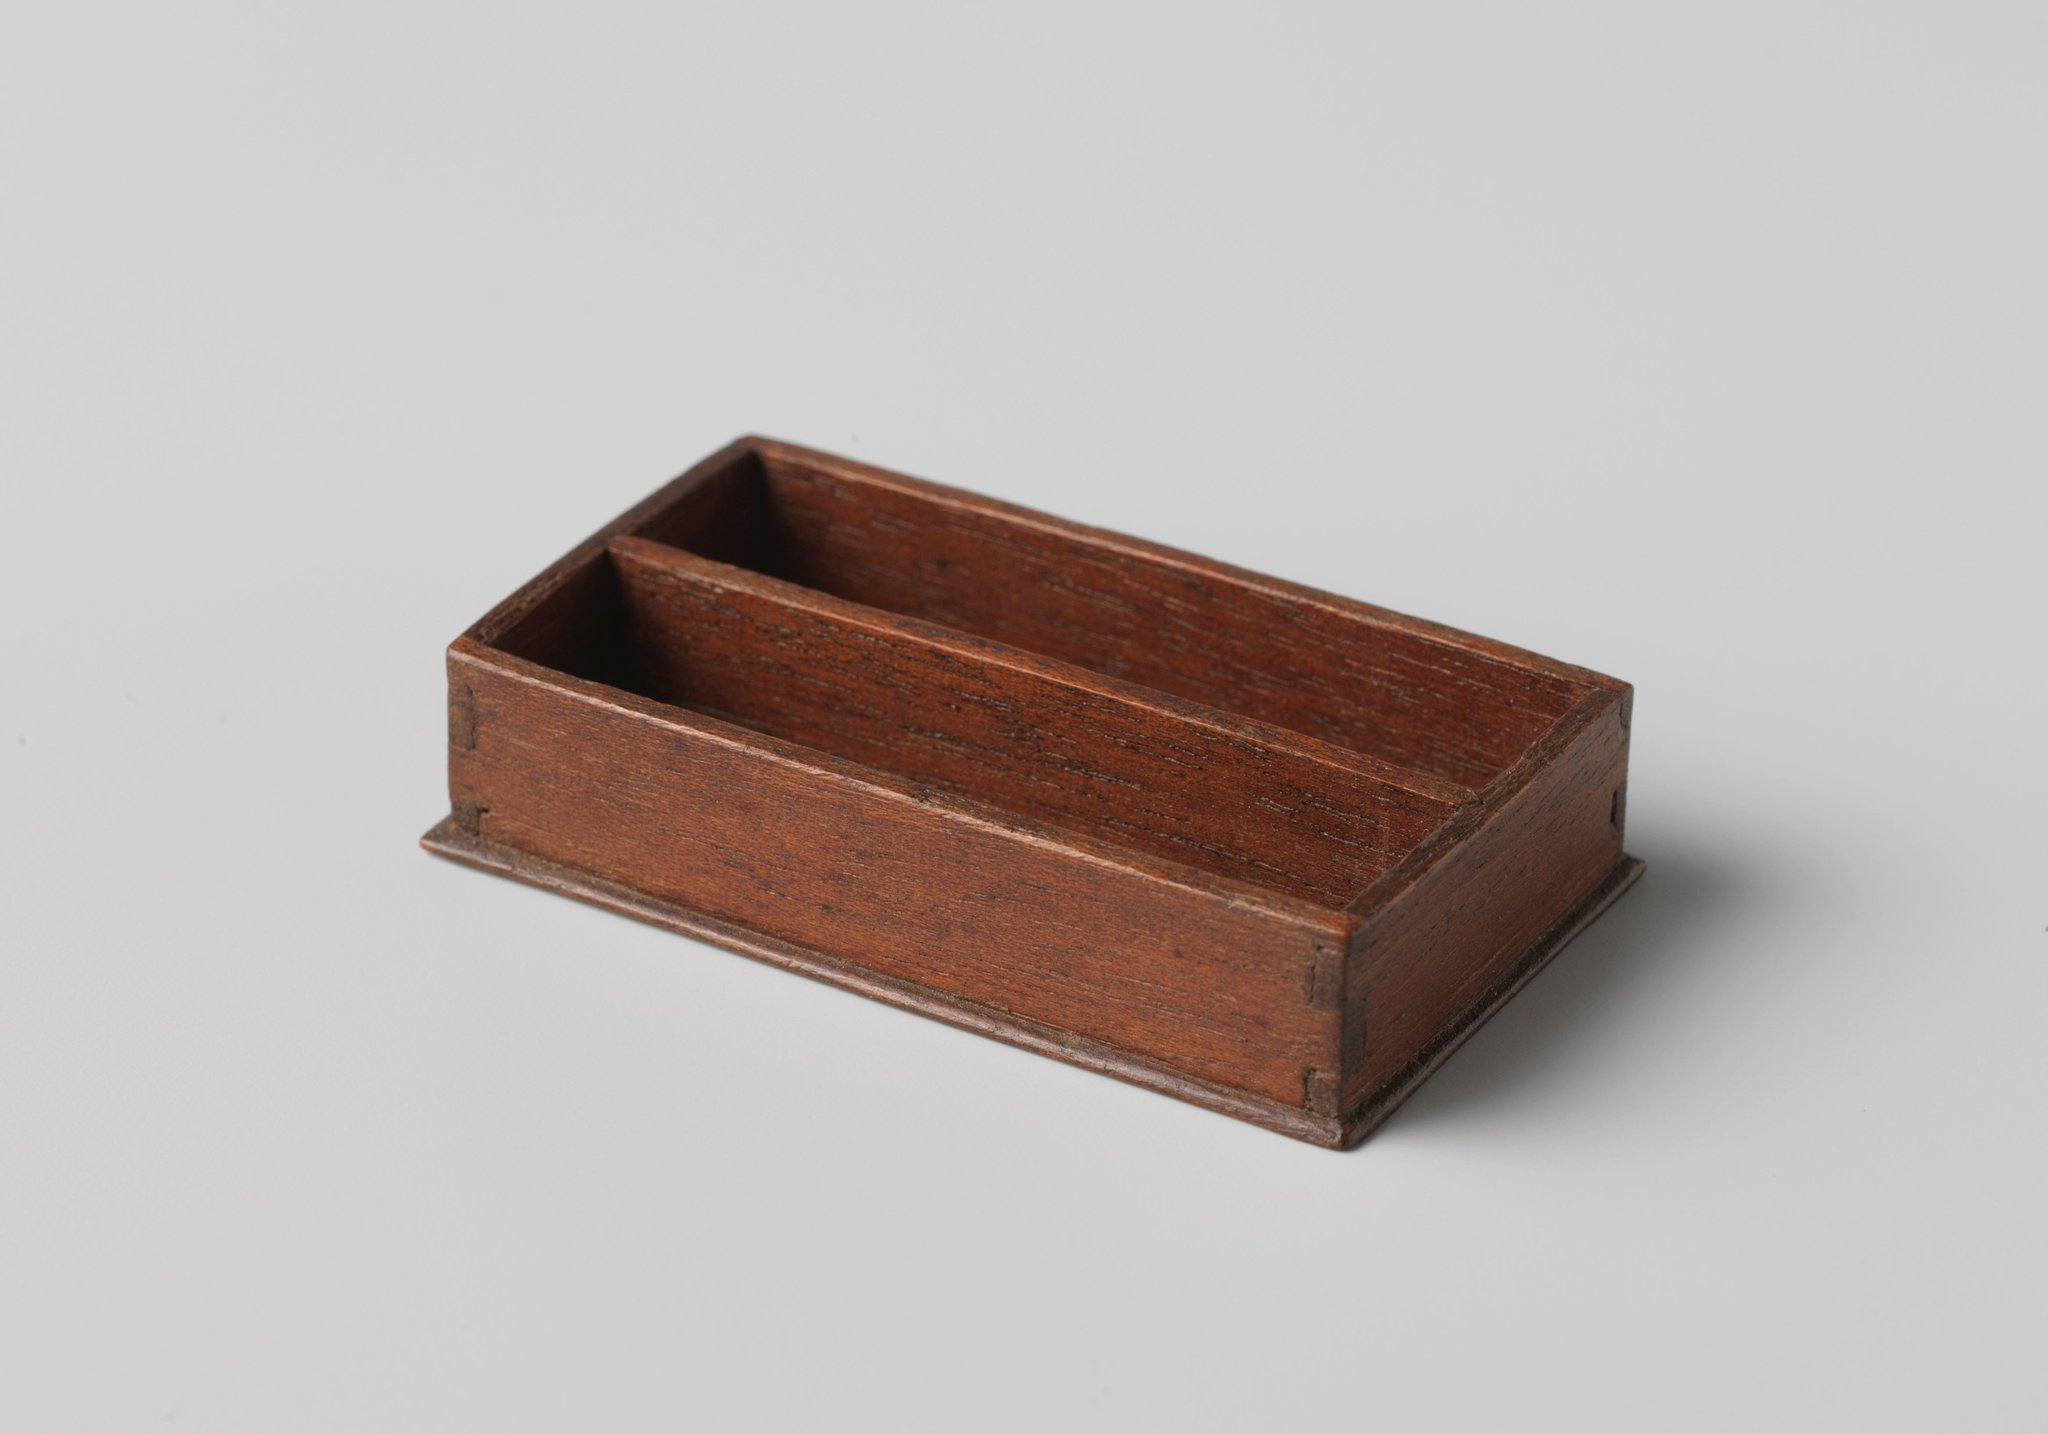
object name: container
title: Messenbak met twee compartimenten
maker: Anonymous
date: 1700-1799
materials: wood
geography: amsterdam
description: Messenbak van mahoniehout met twee compartimenten, iets uitstekend onderblad.